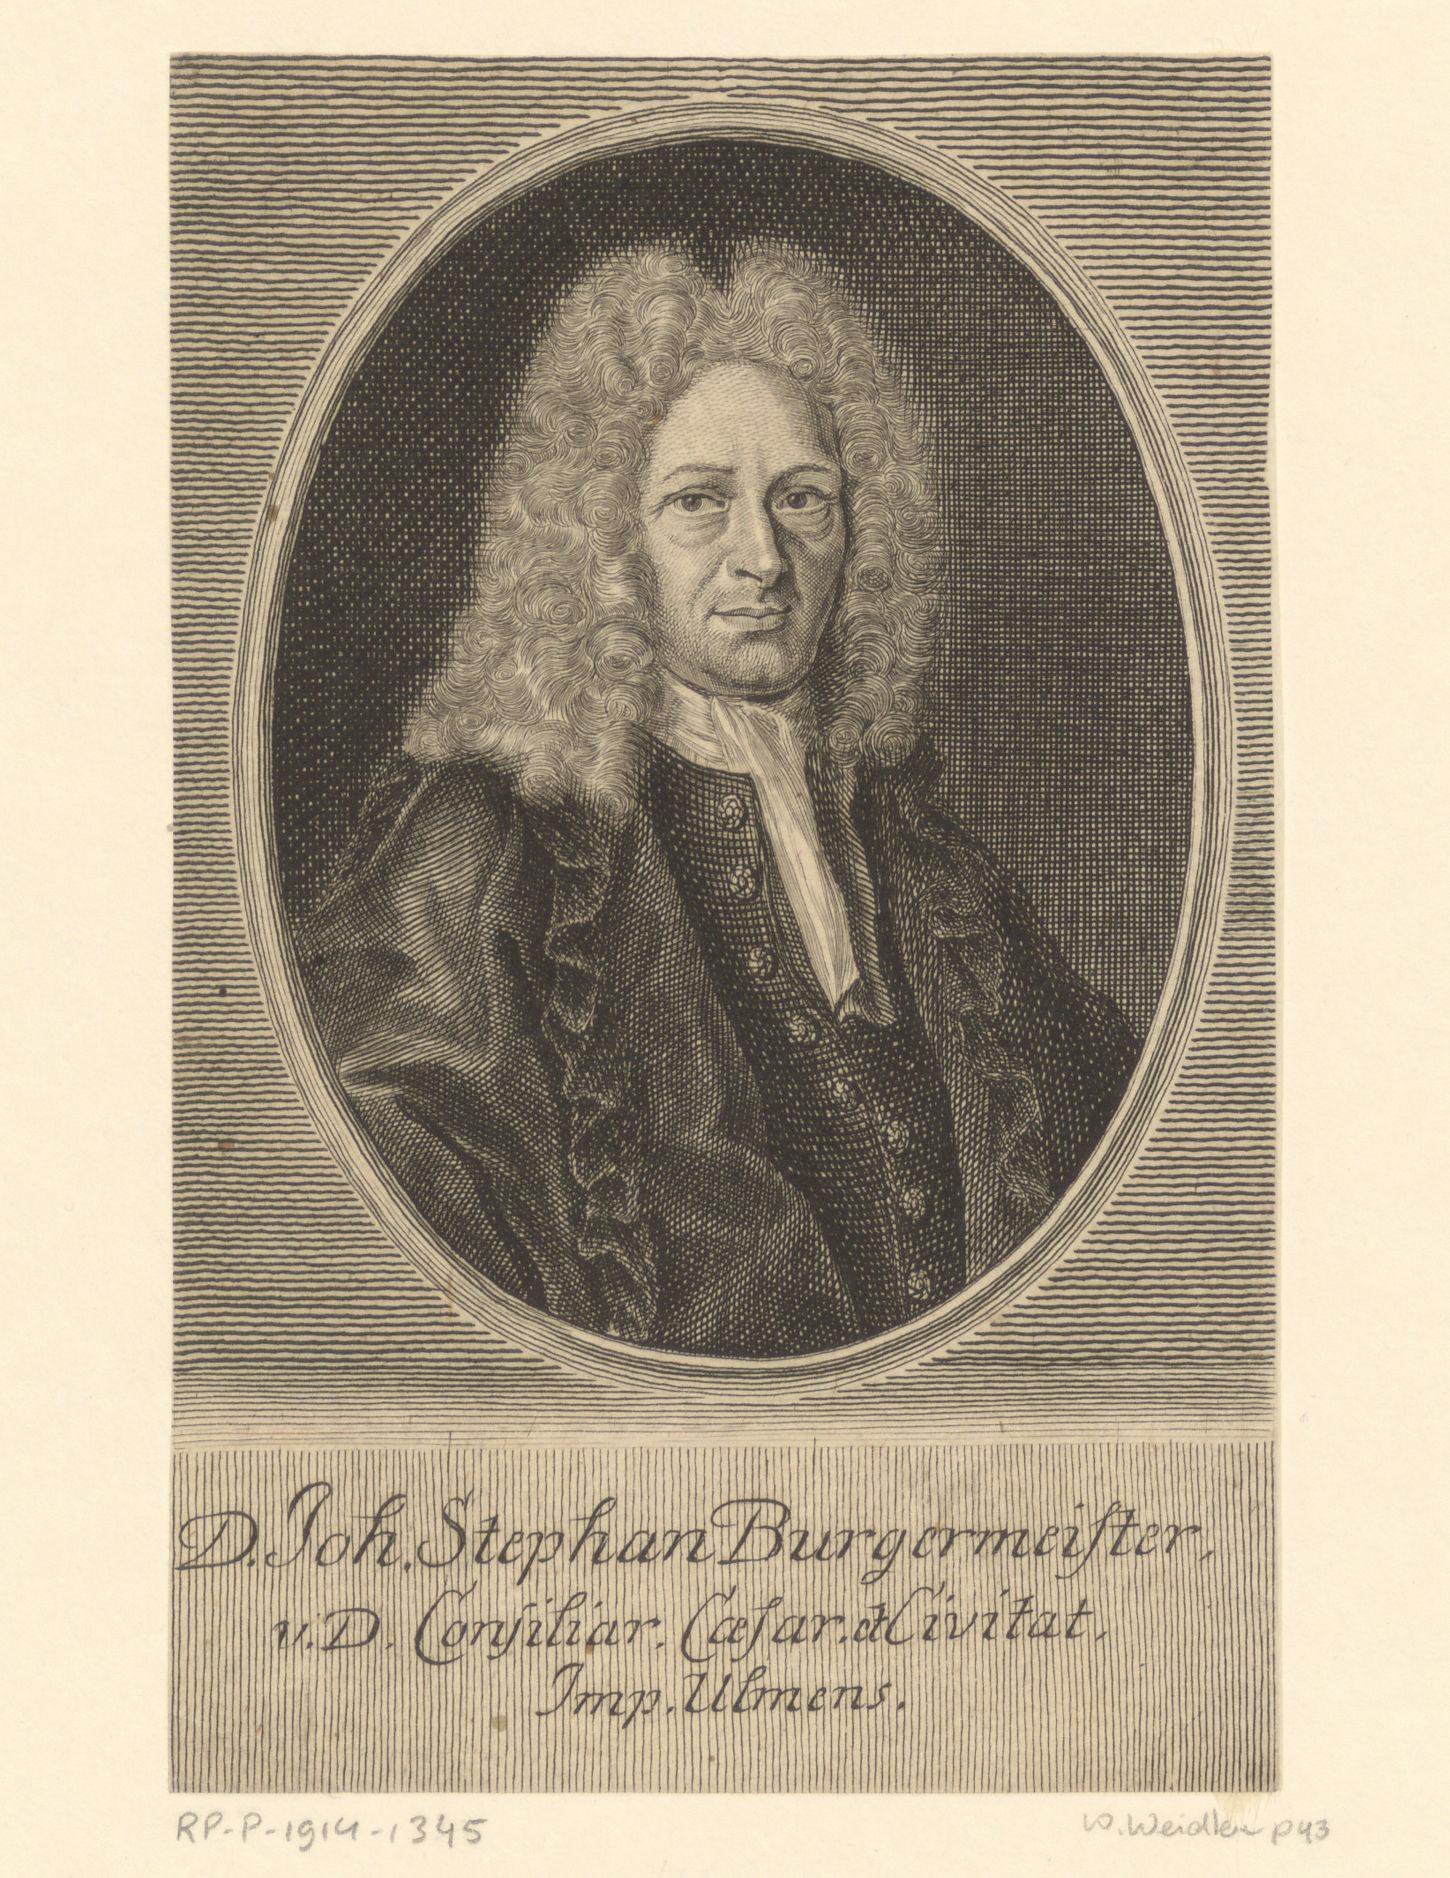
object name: print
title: Portret van Johann Stephan Burgermeister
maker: martin bernigeroth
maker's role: print maker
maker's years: 1670-1733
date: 1722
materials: paper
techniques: engraving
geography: leipzig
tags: historical persons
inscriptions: collector's mark: Lugt 2228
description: Prent ook gebruikt in: Deutsche Acta Eruditorum (...). dl. 77. Leipzig: Johann Gottlieb Gleditsch, 1722.